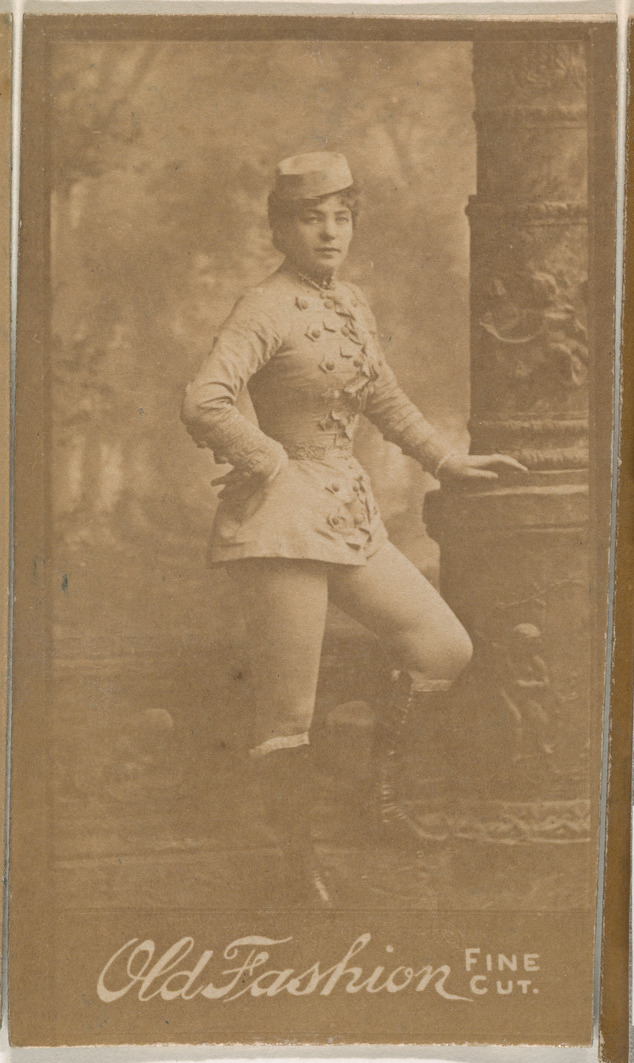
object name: photograph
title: Actress leaning on column, from the Actresses series (N664) promoting Old Fashion Fine Cut Tobacco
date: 1888-1890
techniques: albumen silver print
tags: portraits,women,actresses